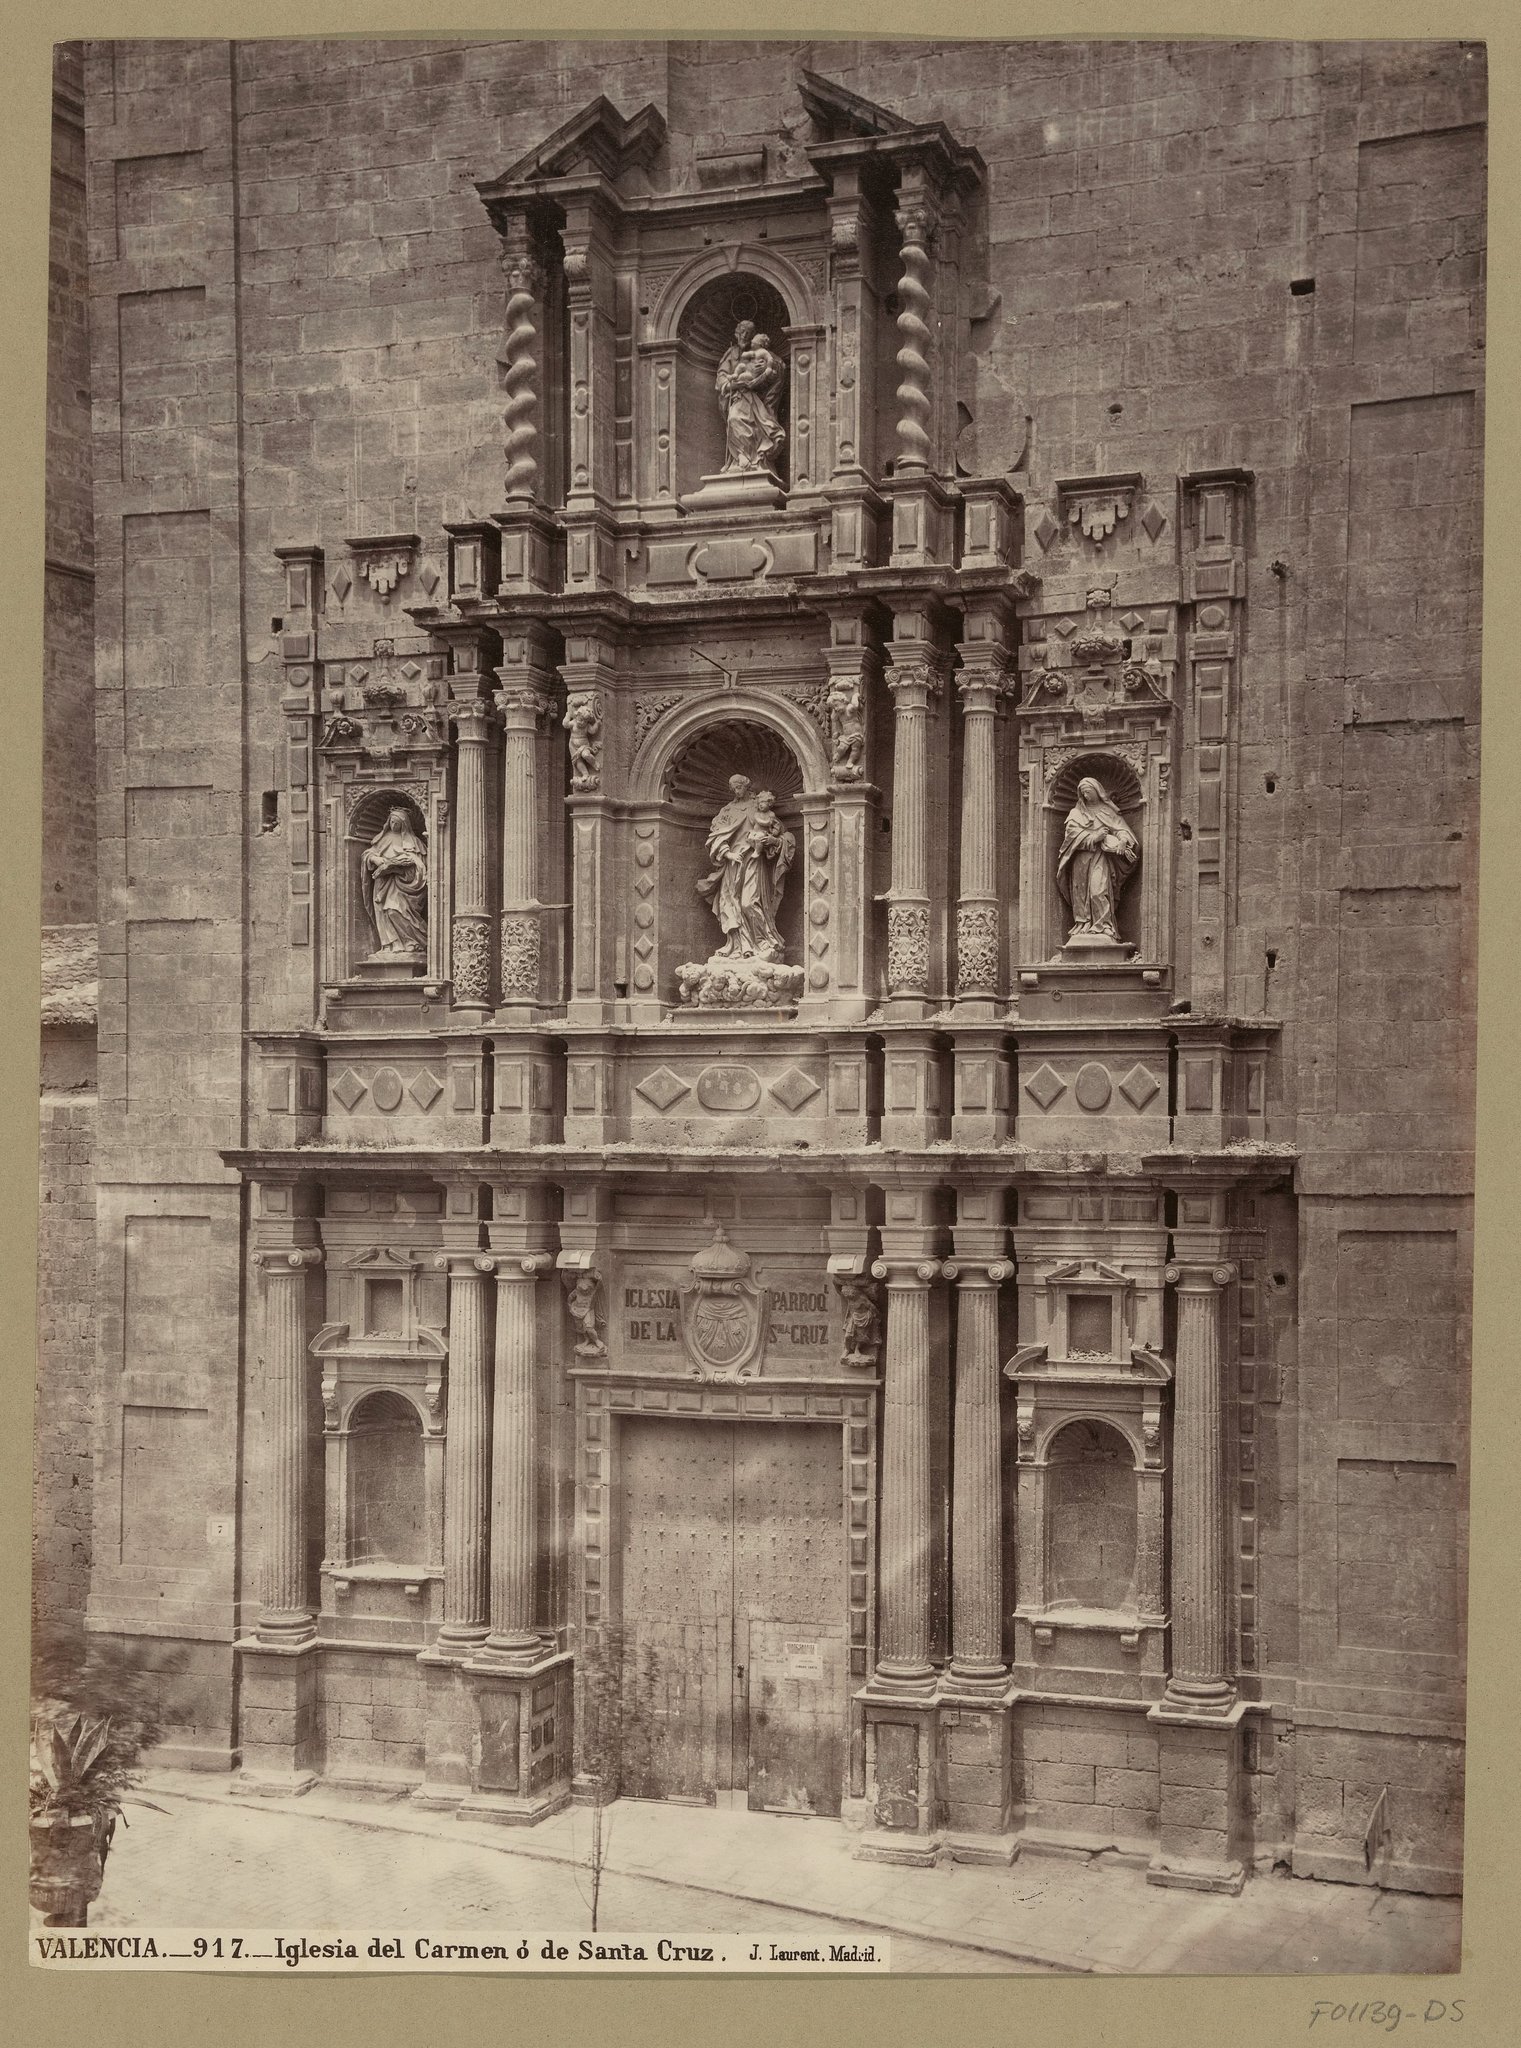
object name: photograph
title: Façade van de Iglesia de la Santa Cruz in Valencia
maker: juan laurent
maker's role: publisher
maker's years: 1816-1896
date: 1856-1863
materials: paper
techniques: albumen print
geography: valencia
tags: parts of church exterior and annexes: portal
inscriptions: number: ‘917.’